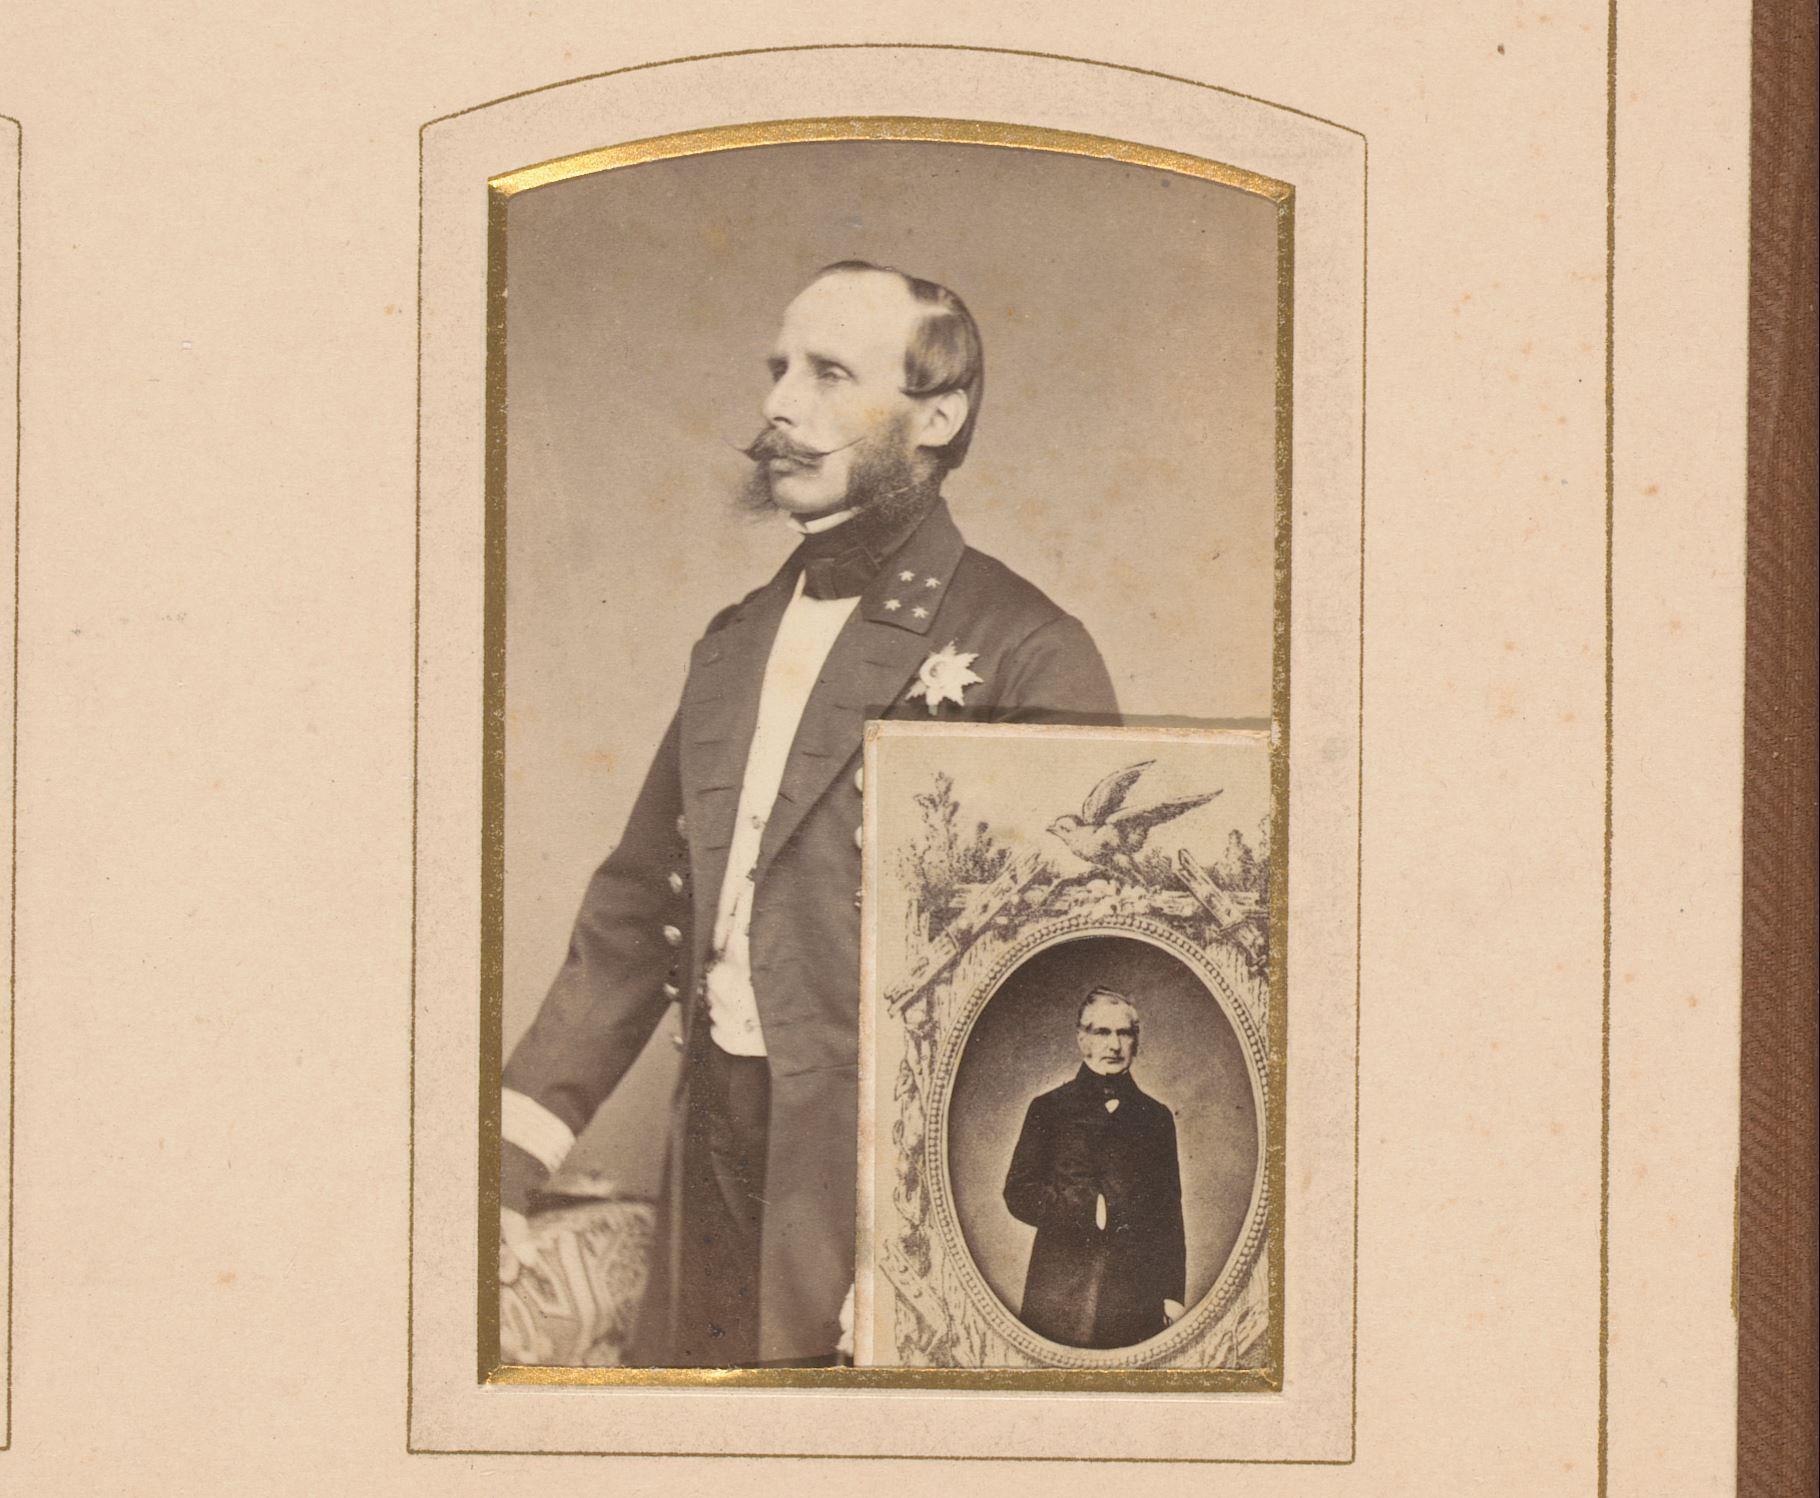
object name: album leaf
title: Portret van een man in lange jas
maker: Anonymous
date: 1850-1900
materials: cardboard, photographic support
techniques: albumen print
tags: historical persons, coat, cape